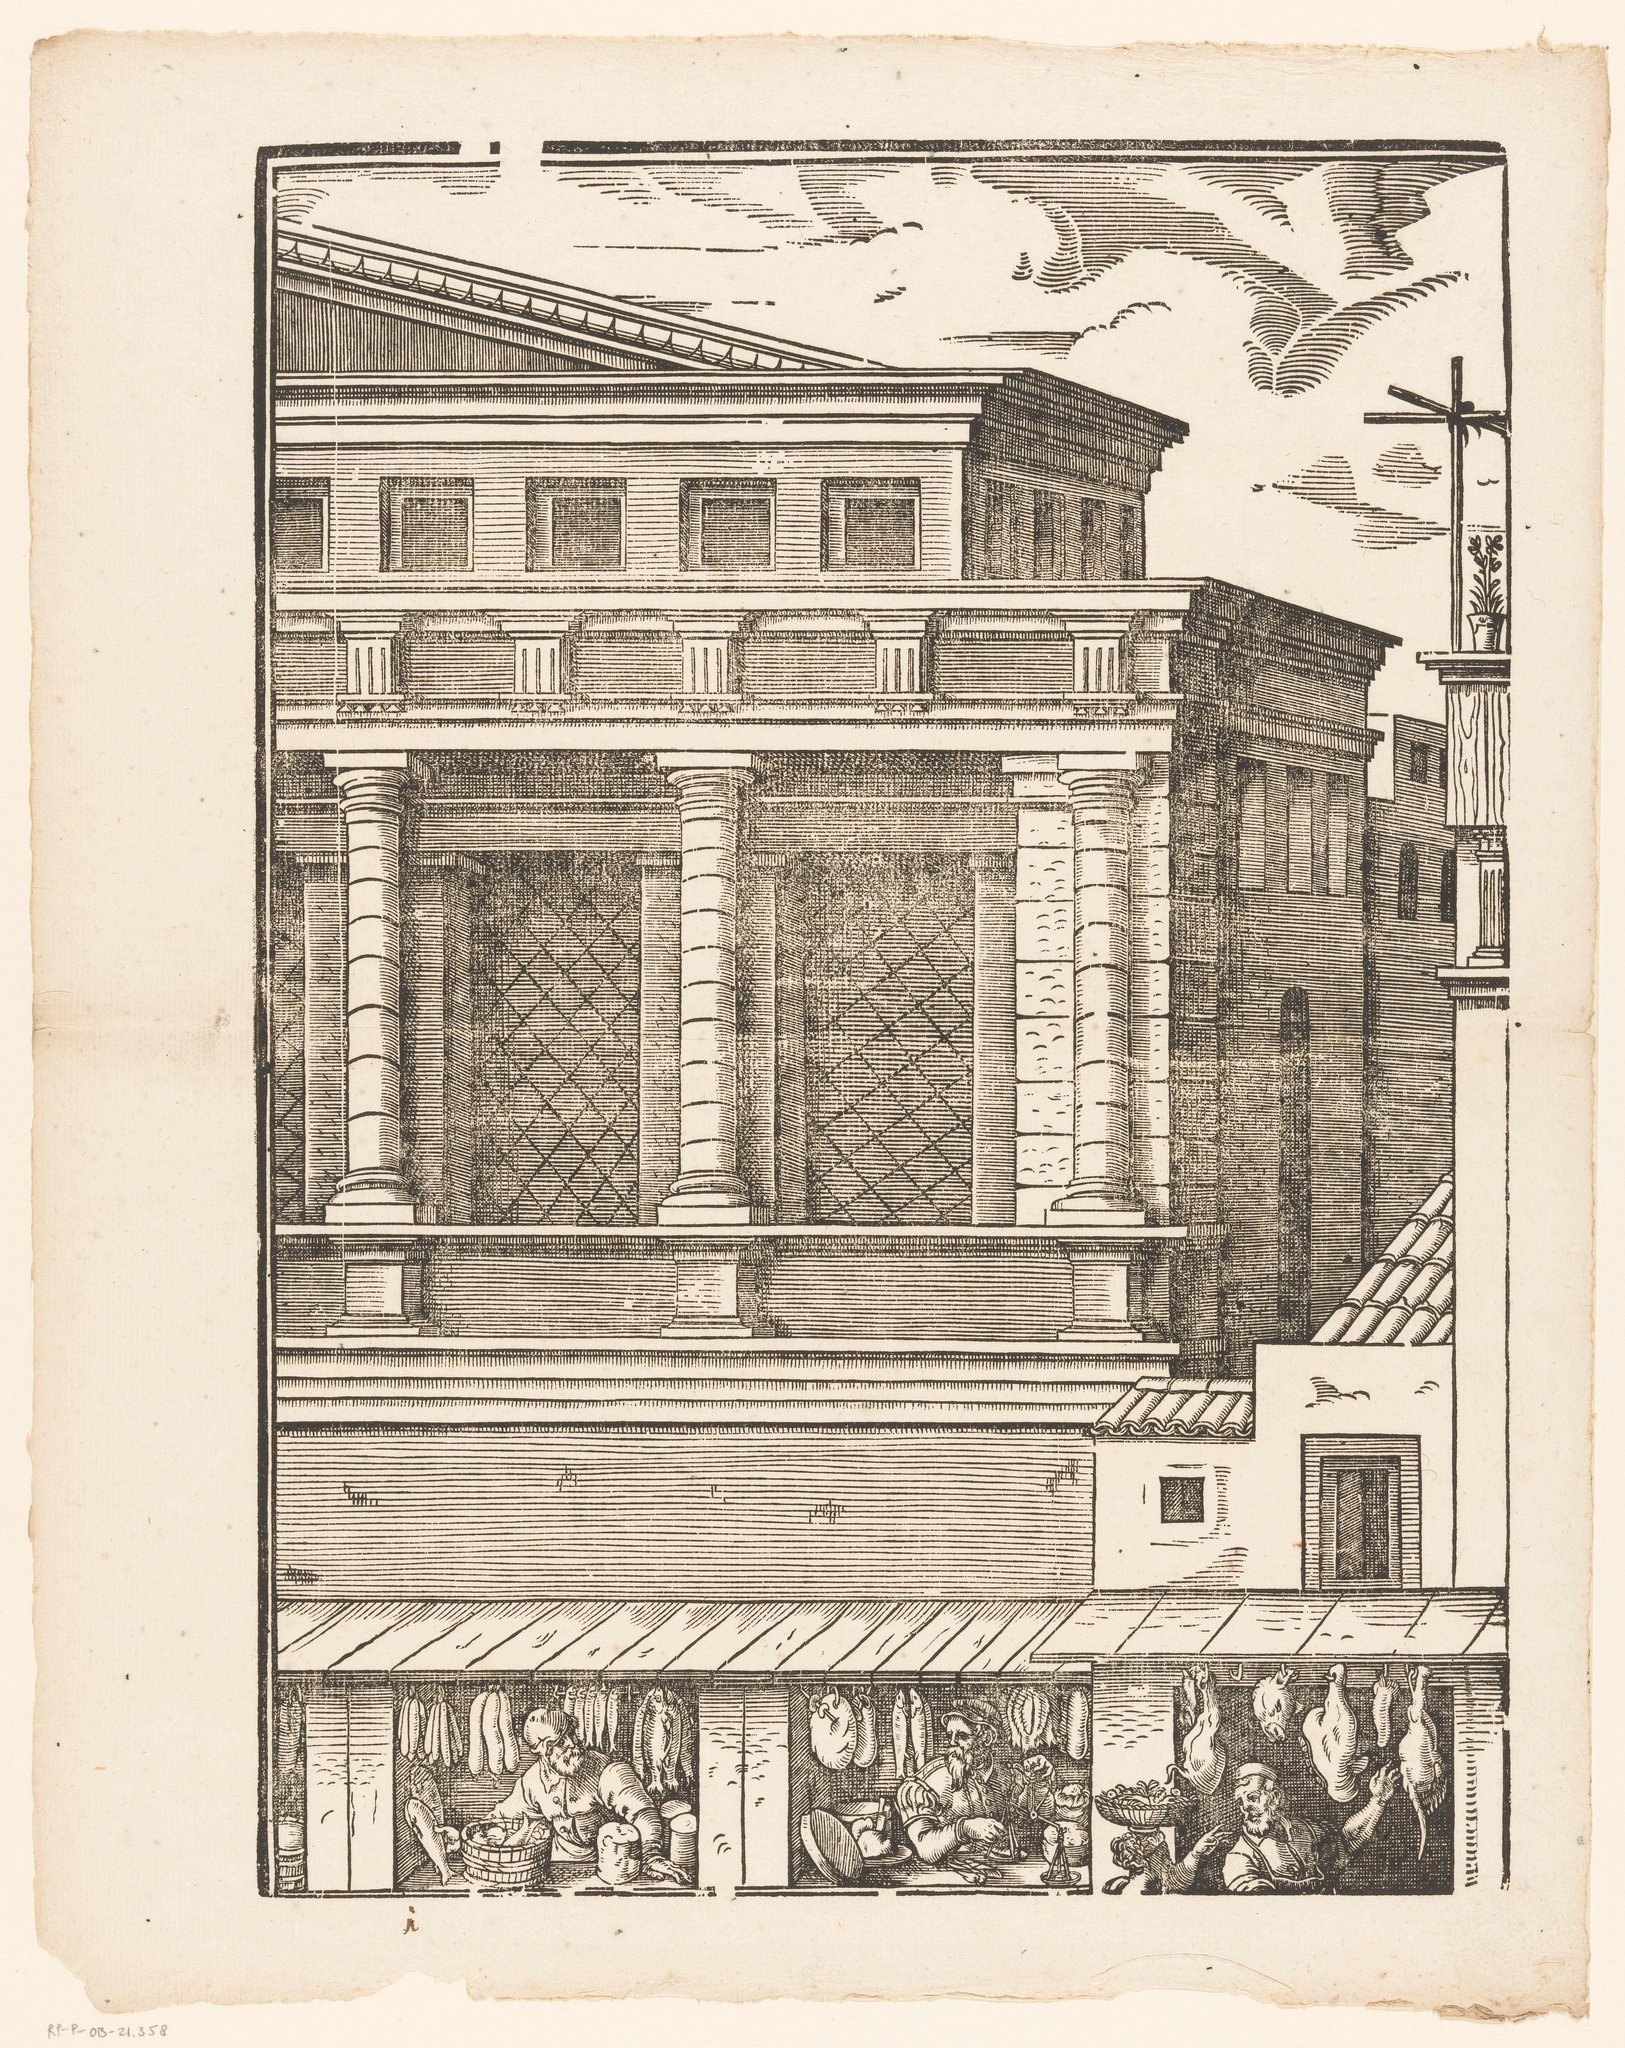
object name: print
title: Festa della Sensa (eerste gedeelte)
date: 1679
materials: paper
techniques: woodcut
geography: nuremberg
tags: city-view in general; 'veduta', procession ~ christian religion, gondola, merchant, salesman, venice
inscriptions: collector's mark: Lugt 240, number: ‘i’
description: Eerste gedeelte van een grote voorstelling van de Festa della Sensa. De voorstelling is gedrukt van veertien blokken, de titel van vijf blokken en het onderschrift bestaat uit vijf delen van elk drie kolommen Duits tekst. In de collectie Rijksmuseum bevinden zich twee complete exemplaren inclusief titel en onderschrift. De veertien blokken die samen de voorstelling vormen zijn in de titels met de klok mee vanaf linksboven genummerd.